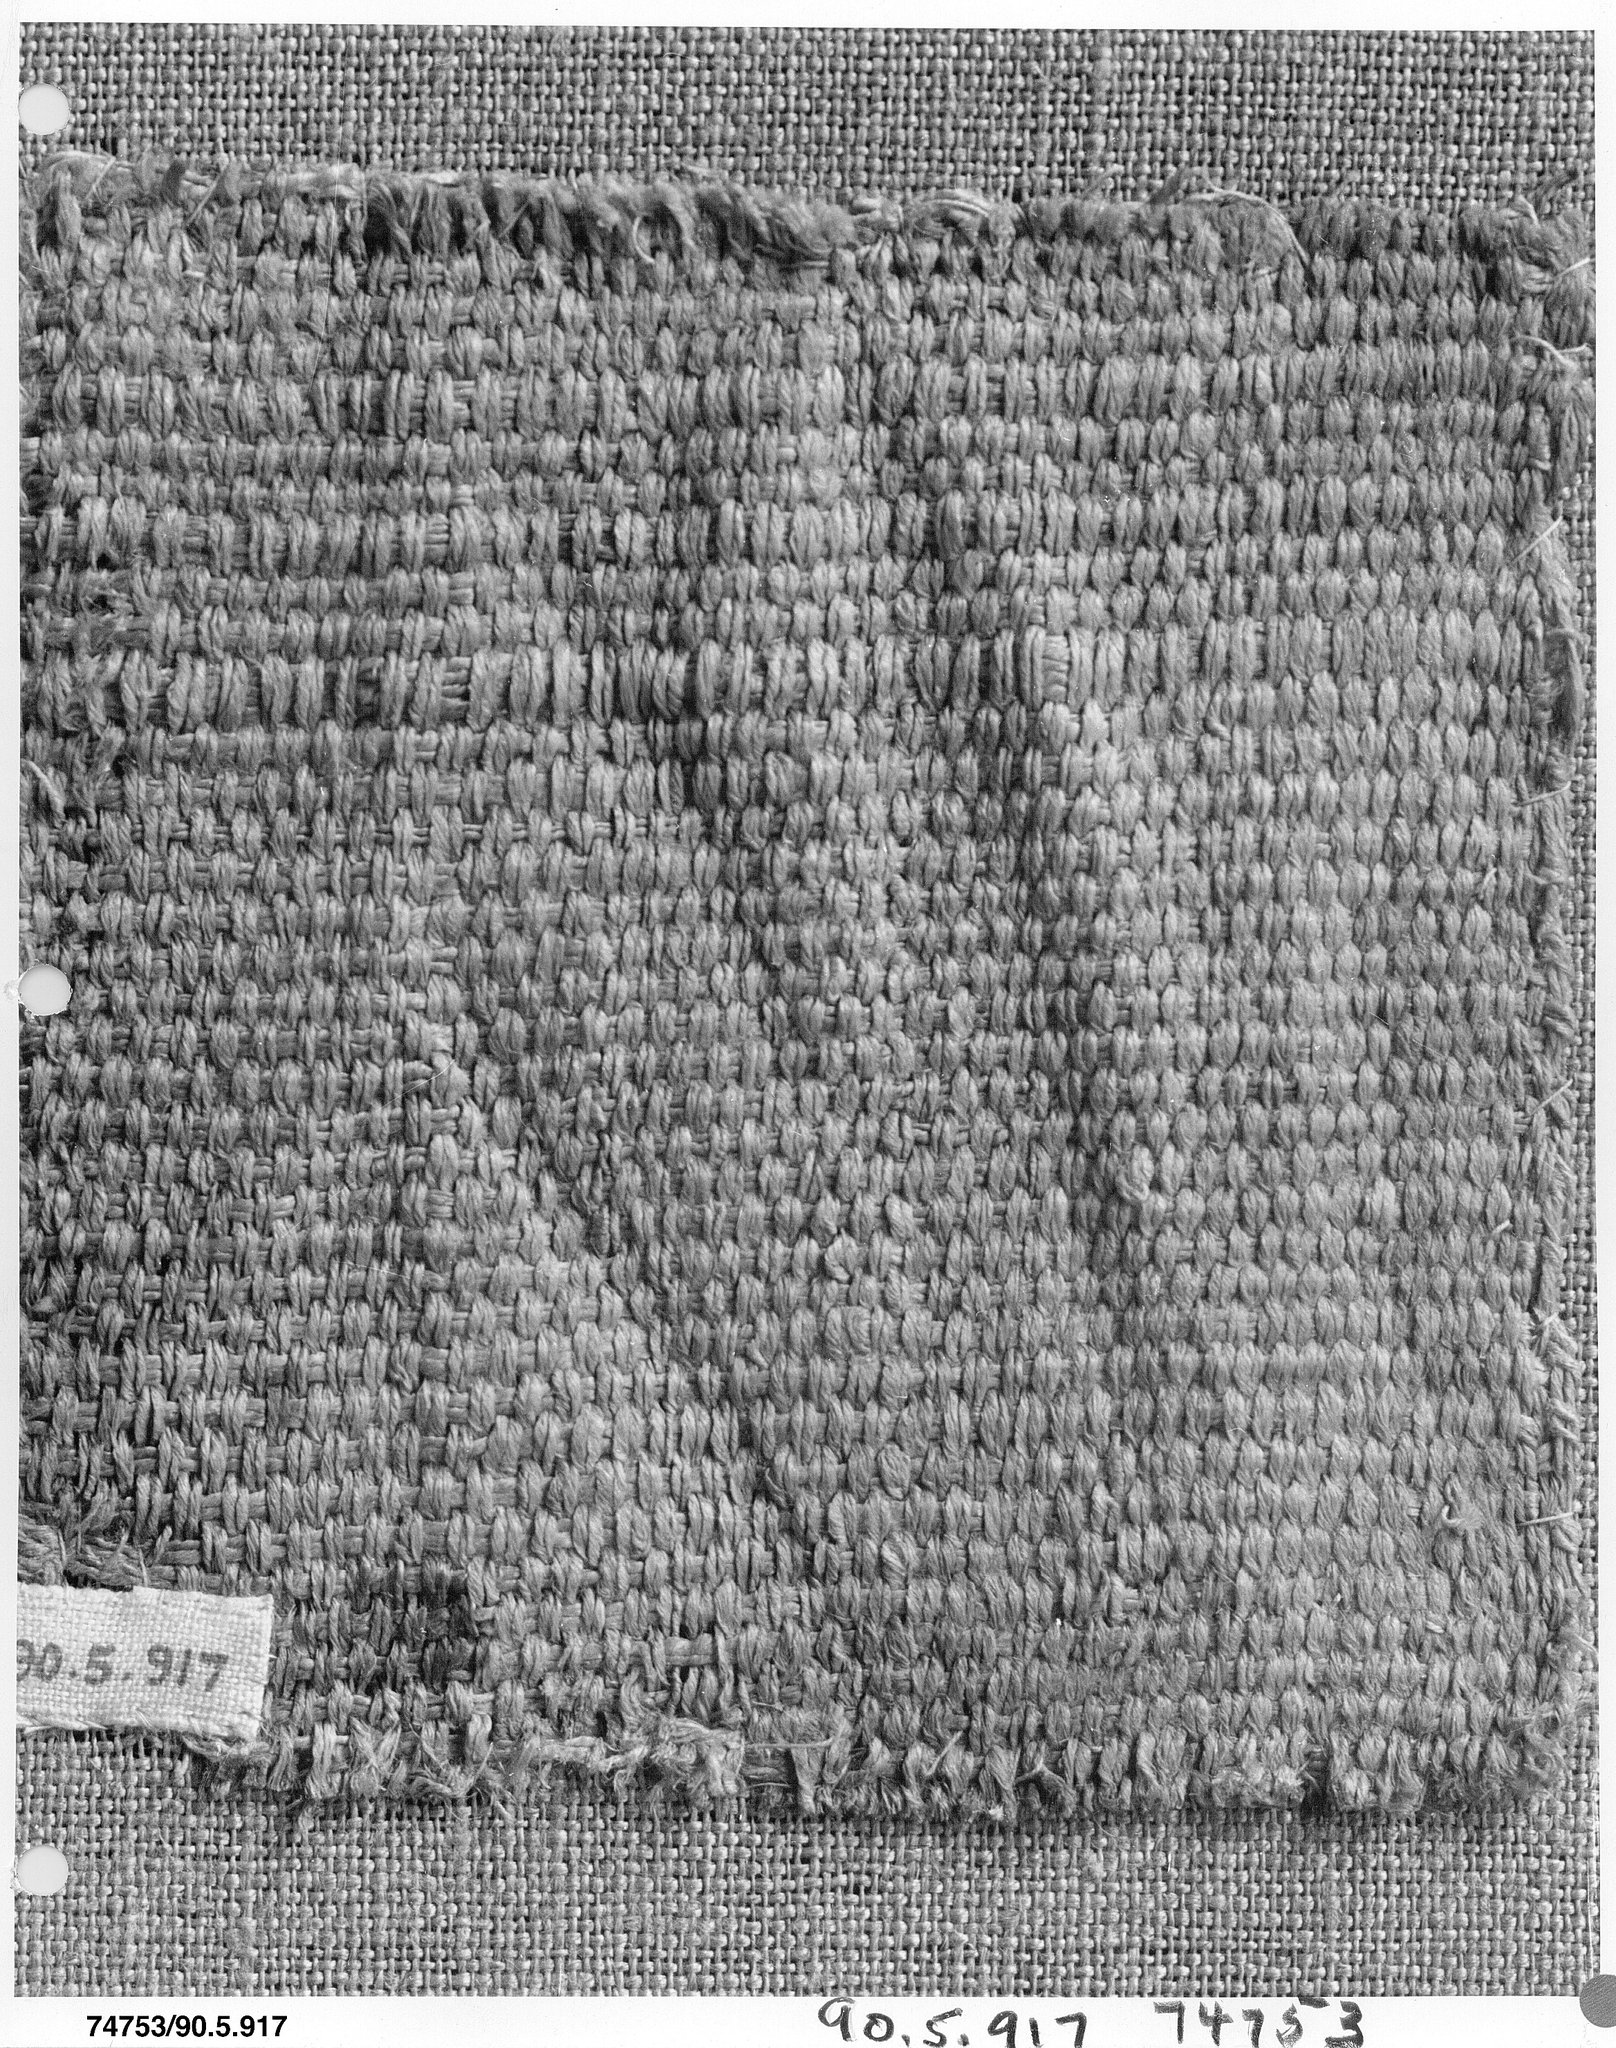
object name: textile fragment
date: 201-400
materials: linen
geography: egypt